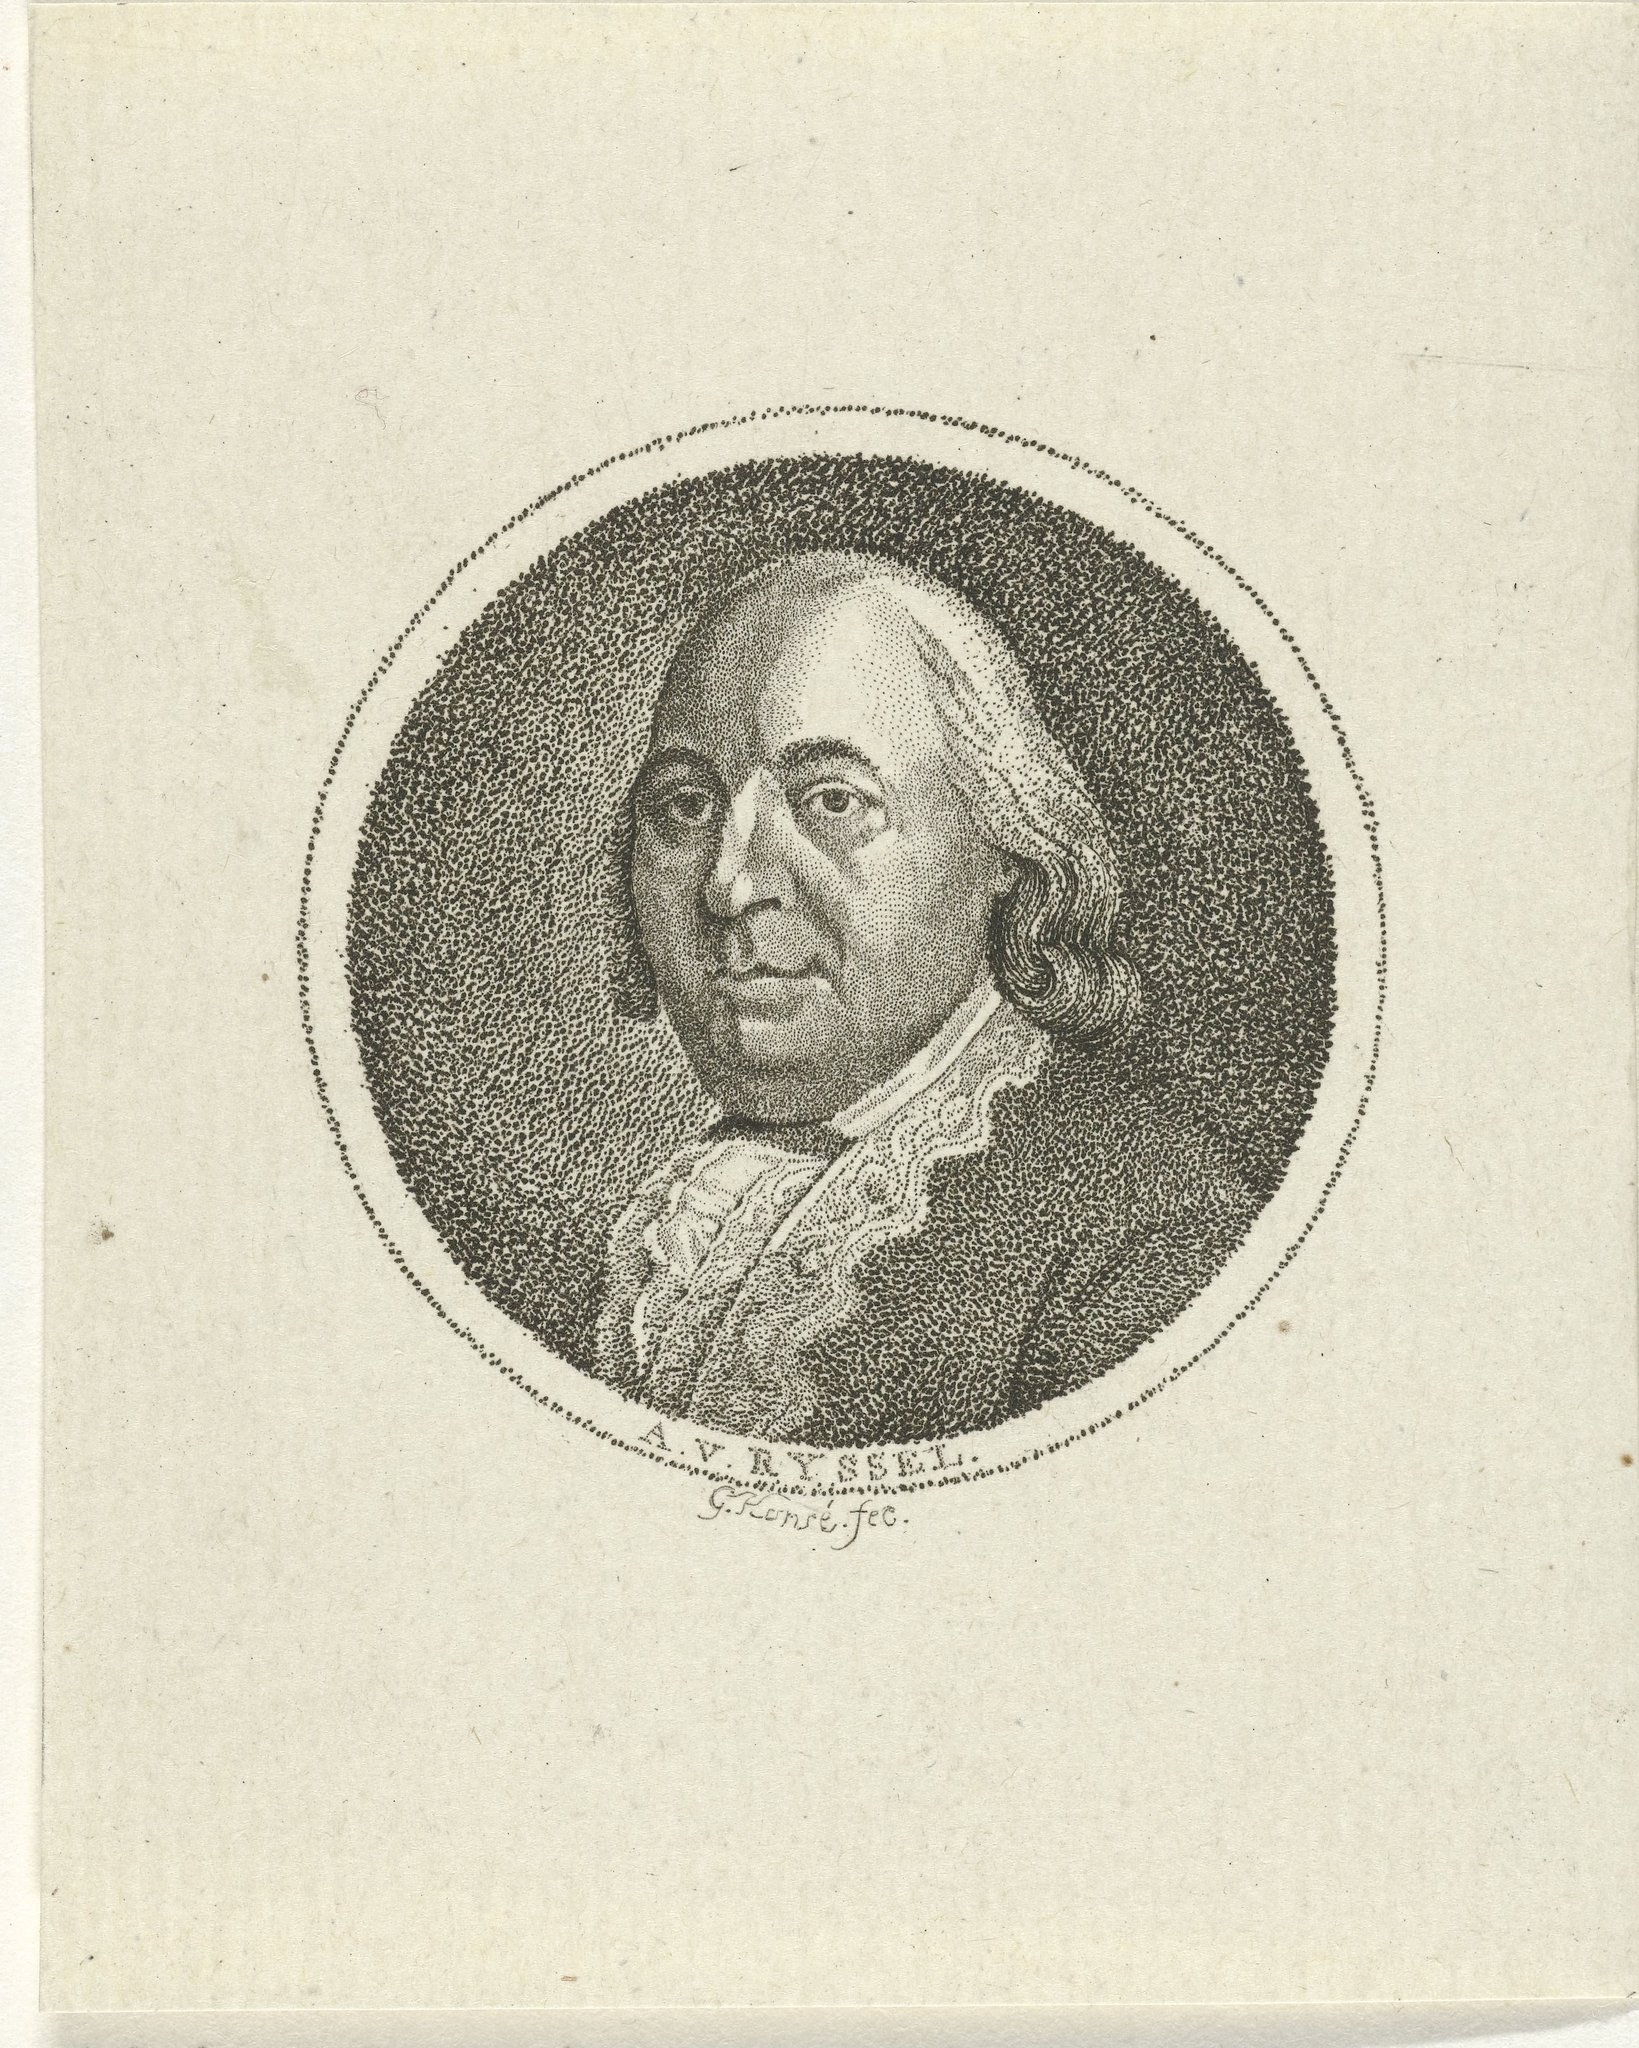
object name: print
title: Portret van Albert van Ryssel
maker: gerrit konsé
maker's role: print maker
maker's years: 1751-1826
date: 1789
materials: paper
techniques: engraving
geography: amsterdam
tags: generaal-majoor, albert van ryssel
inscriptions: collector's mark: Lugt 2228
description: Portretbuste naar links in een cirkelvormige omlijsting van Albert van Ryssel, generaal-majoor in 1787.